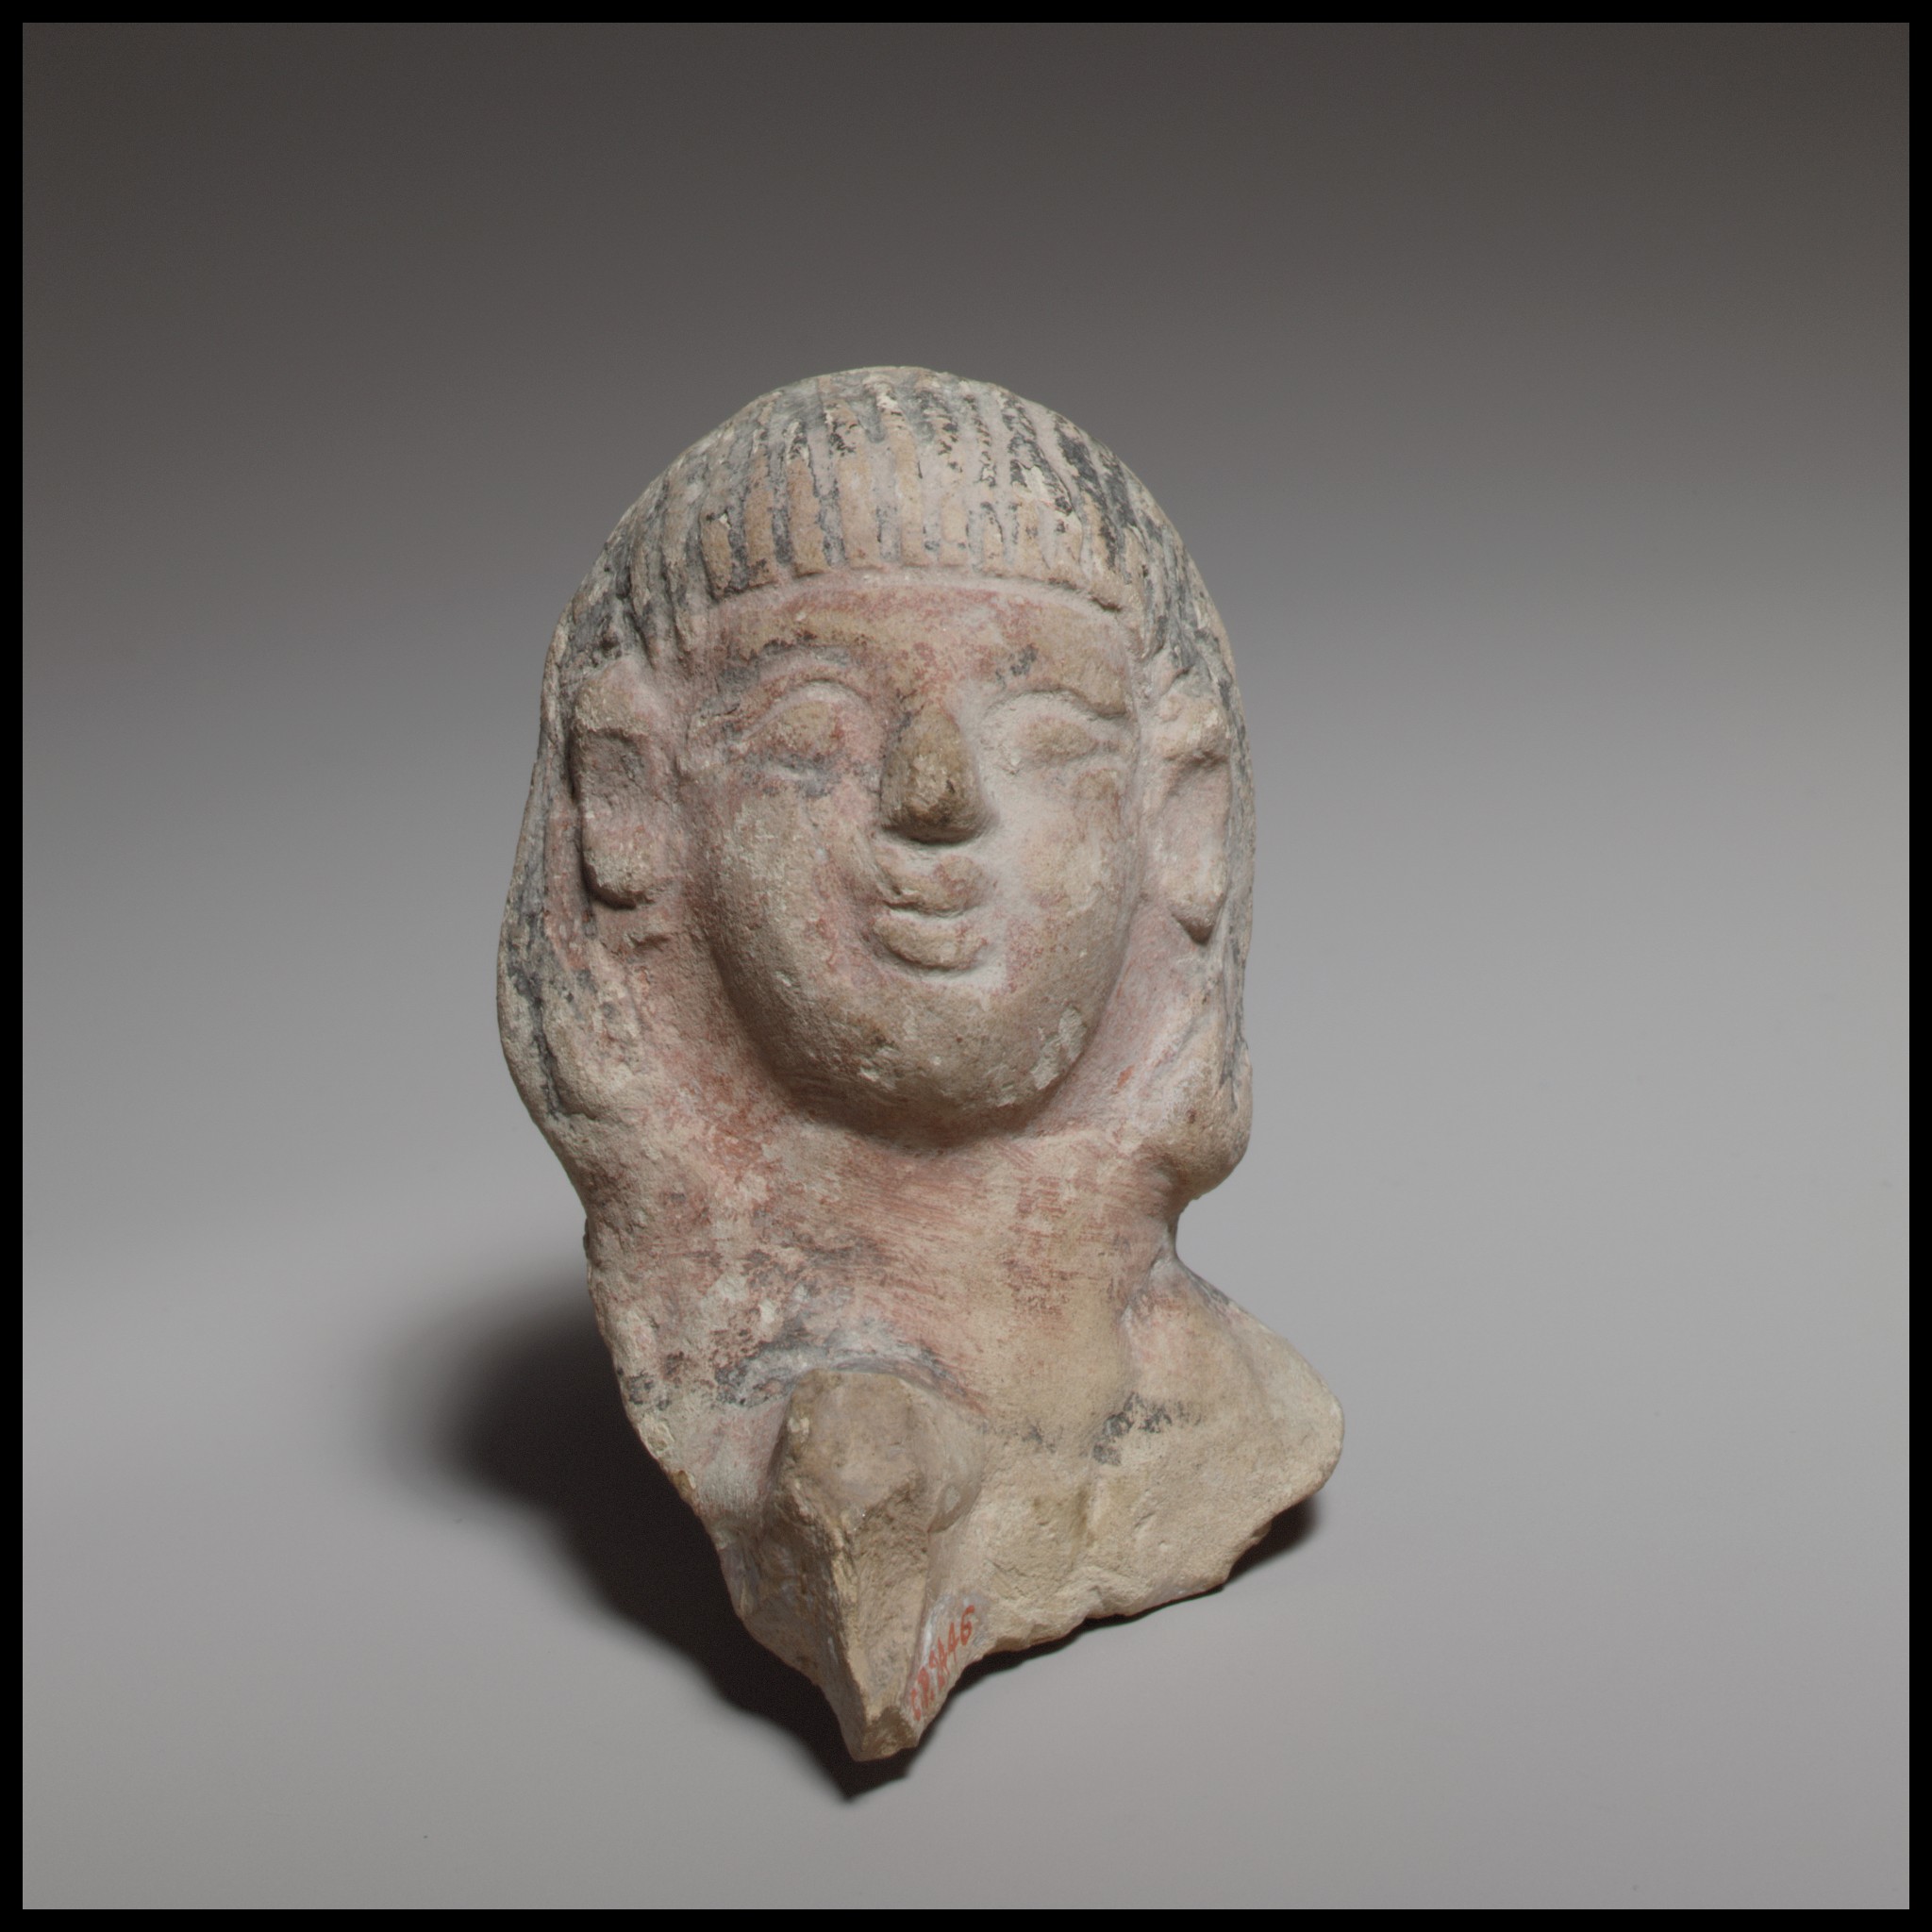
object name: head of a votary, female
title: Female head, perhaps from a standing tambourine player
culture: cypriot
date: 600-480 BCE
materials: terracotta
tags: heads,women